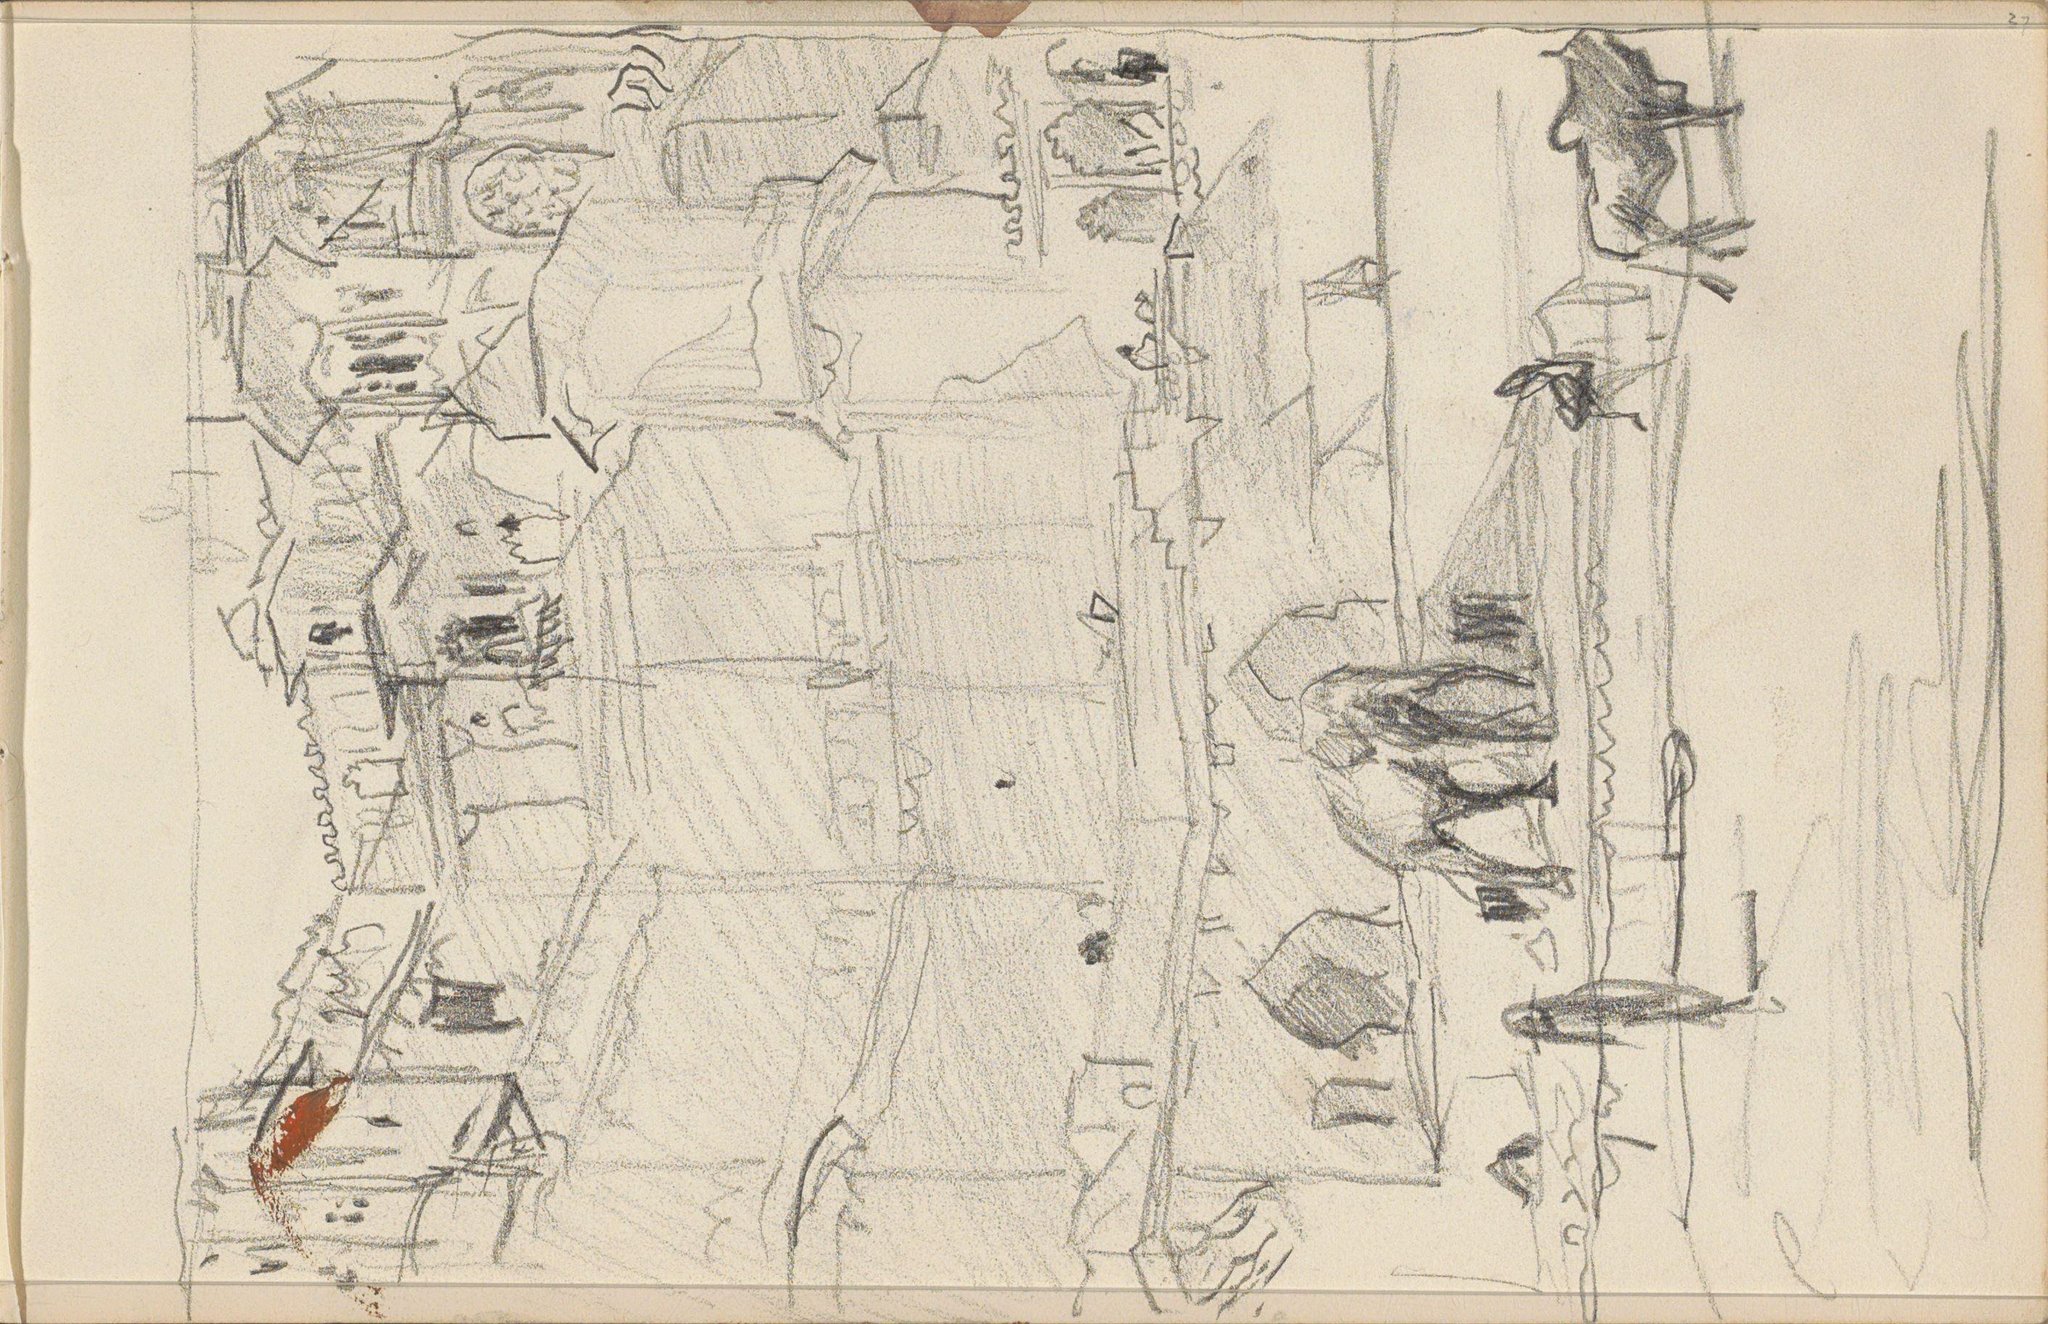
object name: sketchbook leaf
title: Straat met een olifant en figuren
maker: marius bauer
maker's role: draughtsman, print maker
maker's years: 1867-1932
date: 1924-1925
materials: paper, pencil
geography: india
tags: trunked animals: elephant, street (+ city(-scape) with figures, staffage)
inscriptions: kleurnotitie, handgeschreven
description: Pagina 37 uit een schetsboek met 48 bladen.